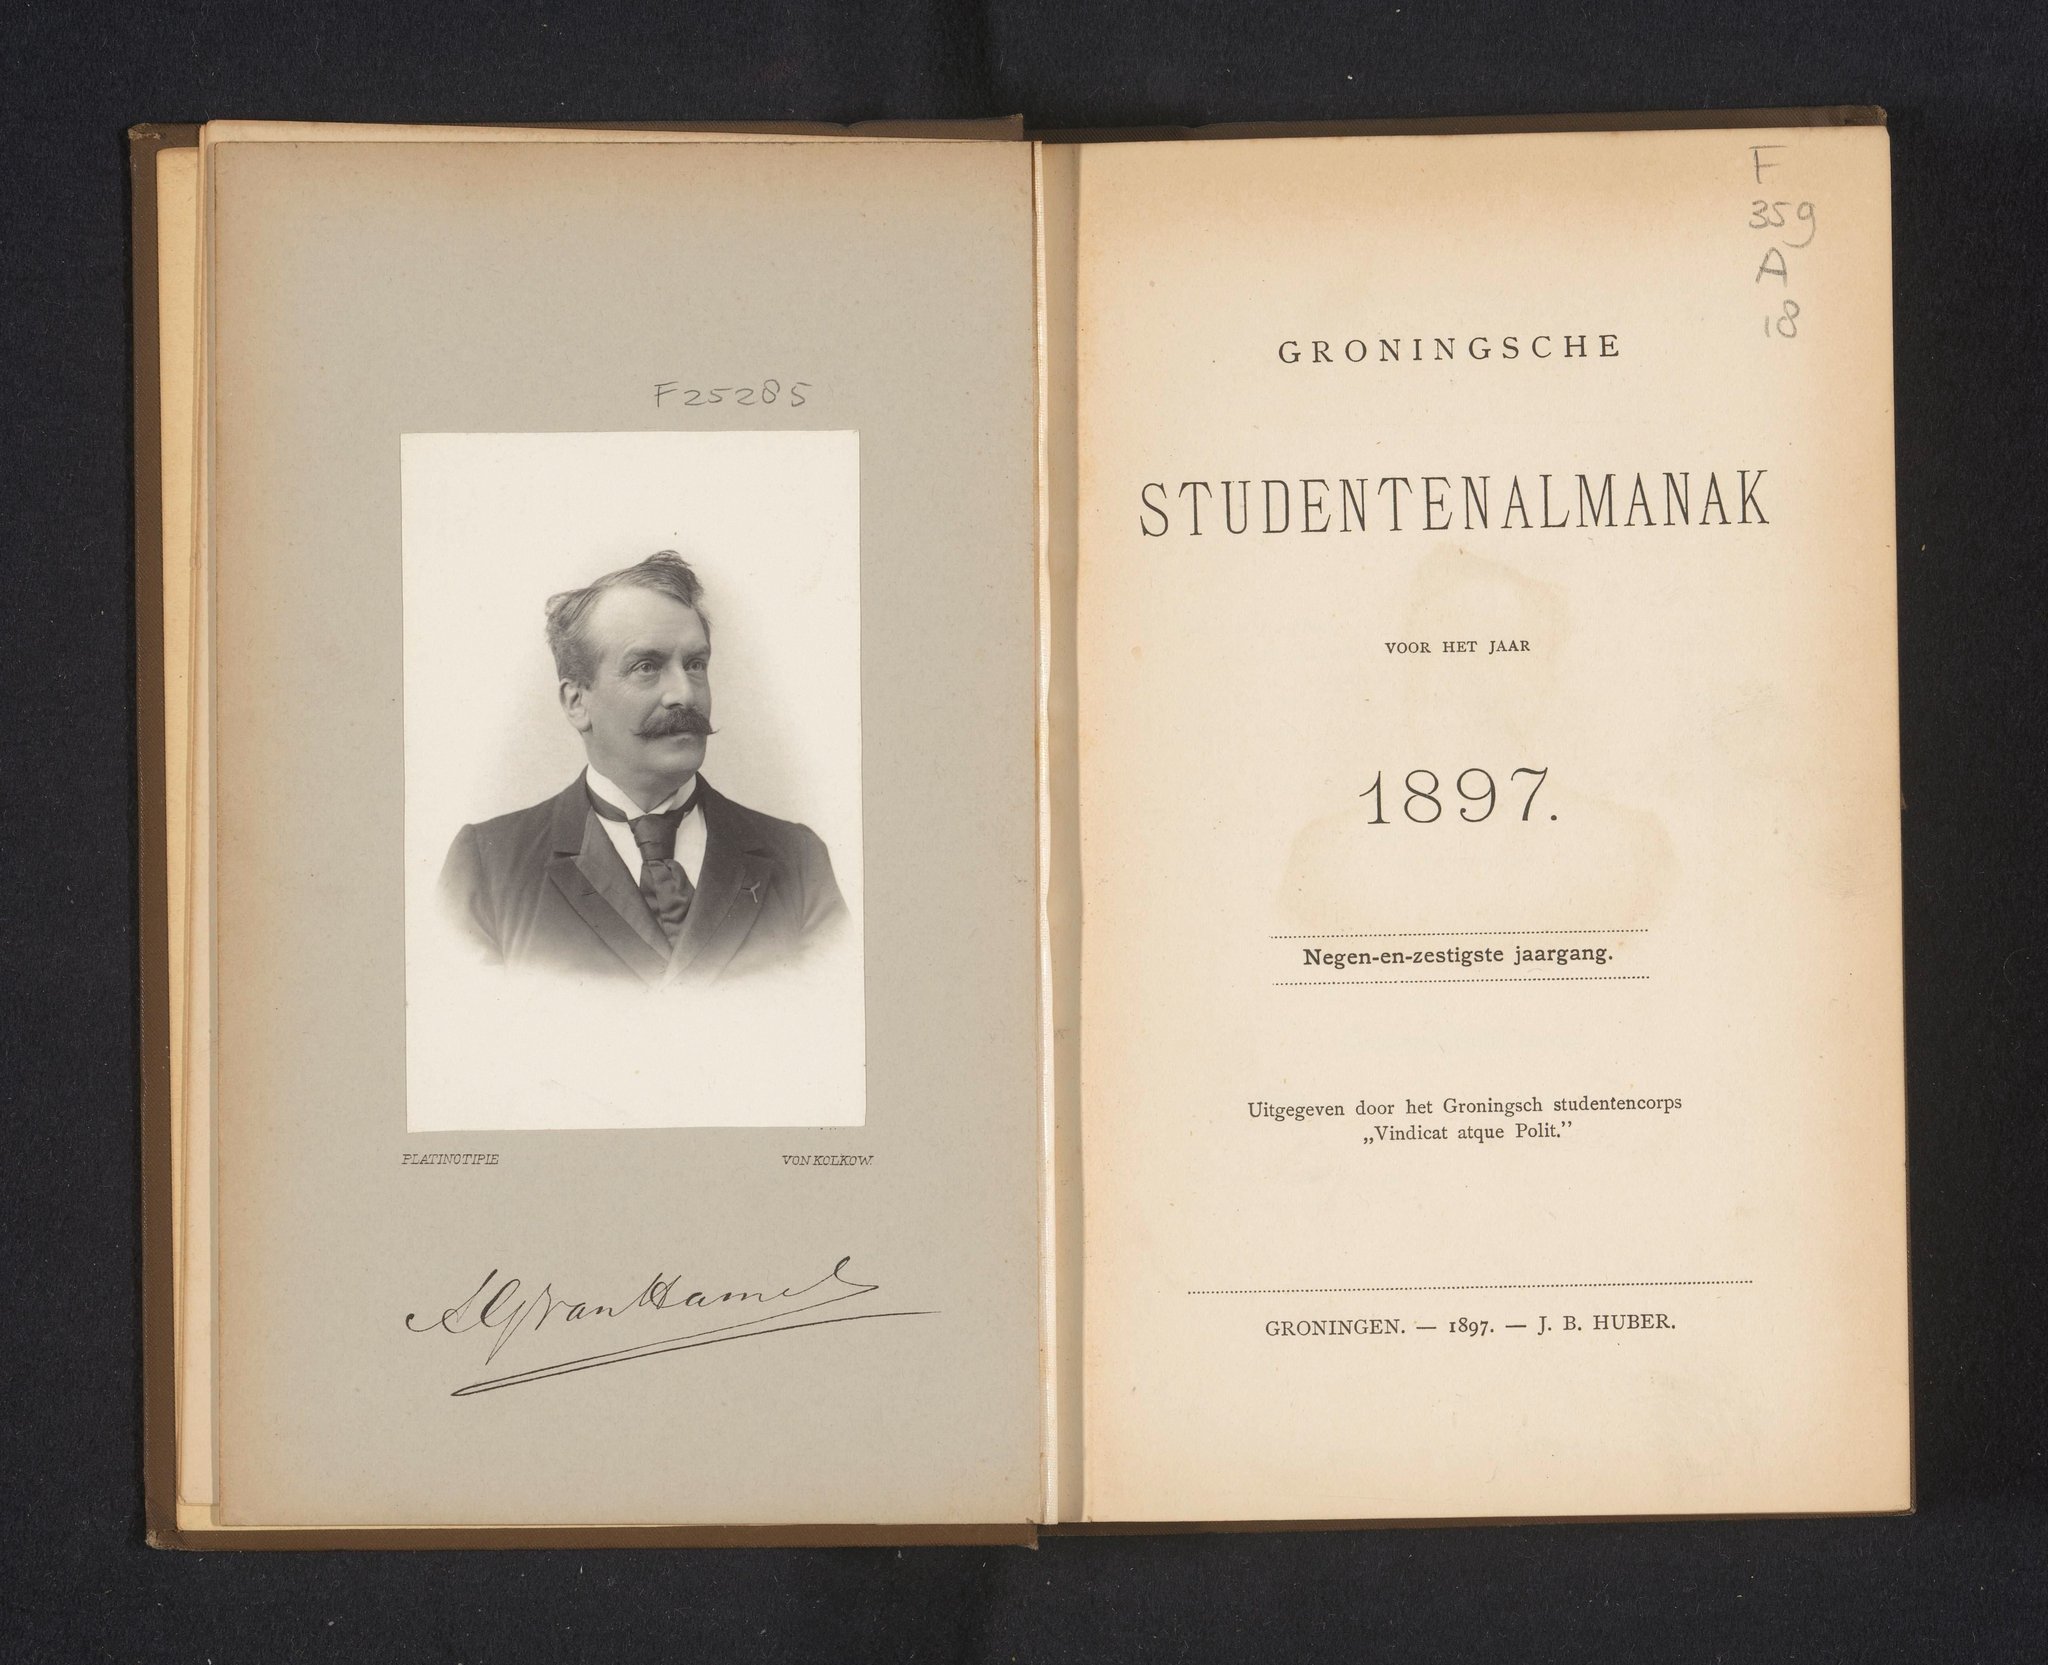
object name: book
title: Groninger studenten almanak voor het jaar 1897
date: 1897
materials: cardboard, linen, paper, photographic support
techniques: platinum process, printing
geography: groningen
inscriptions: annotation: ‘qt/ h-vv’, annotation: ‘gekocht maart 1965 f 1.50/ bij [...] Amsterdam’